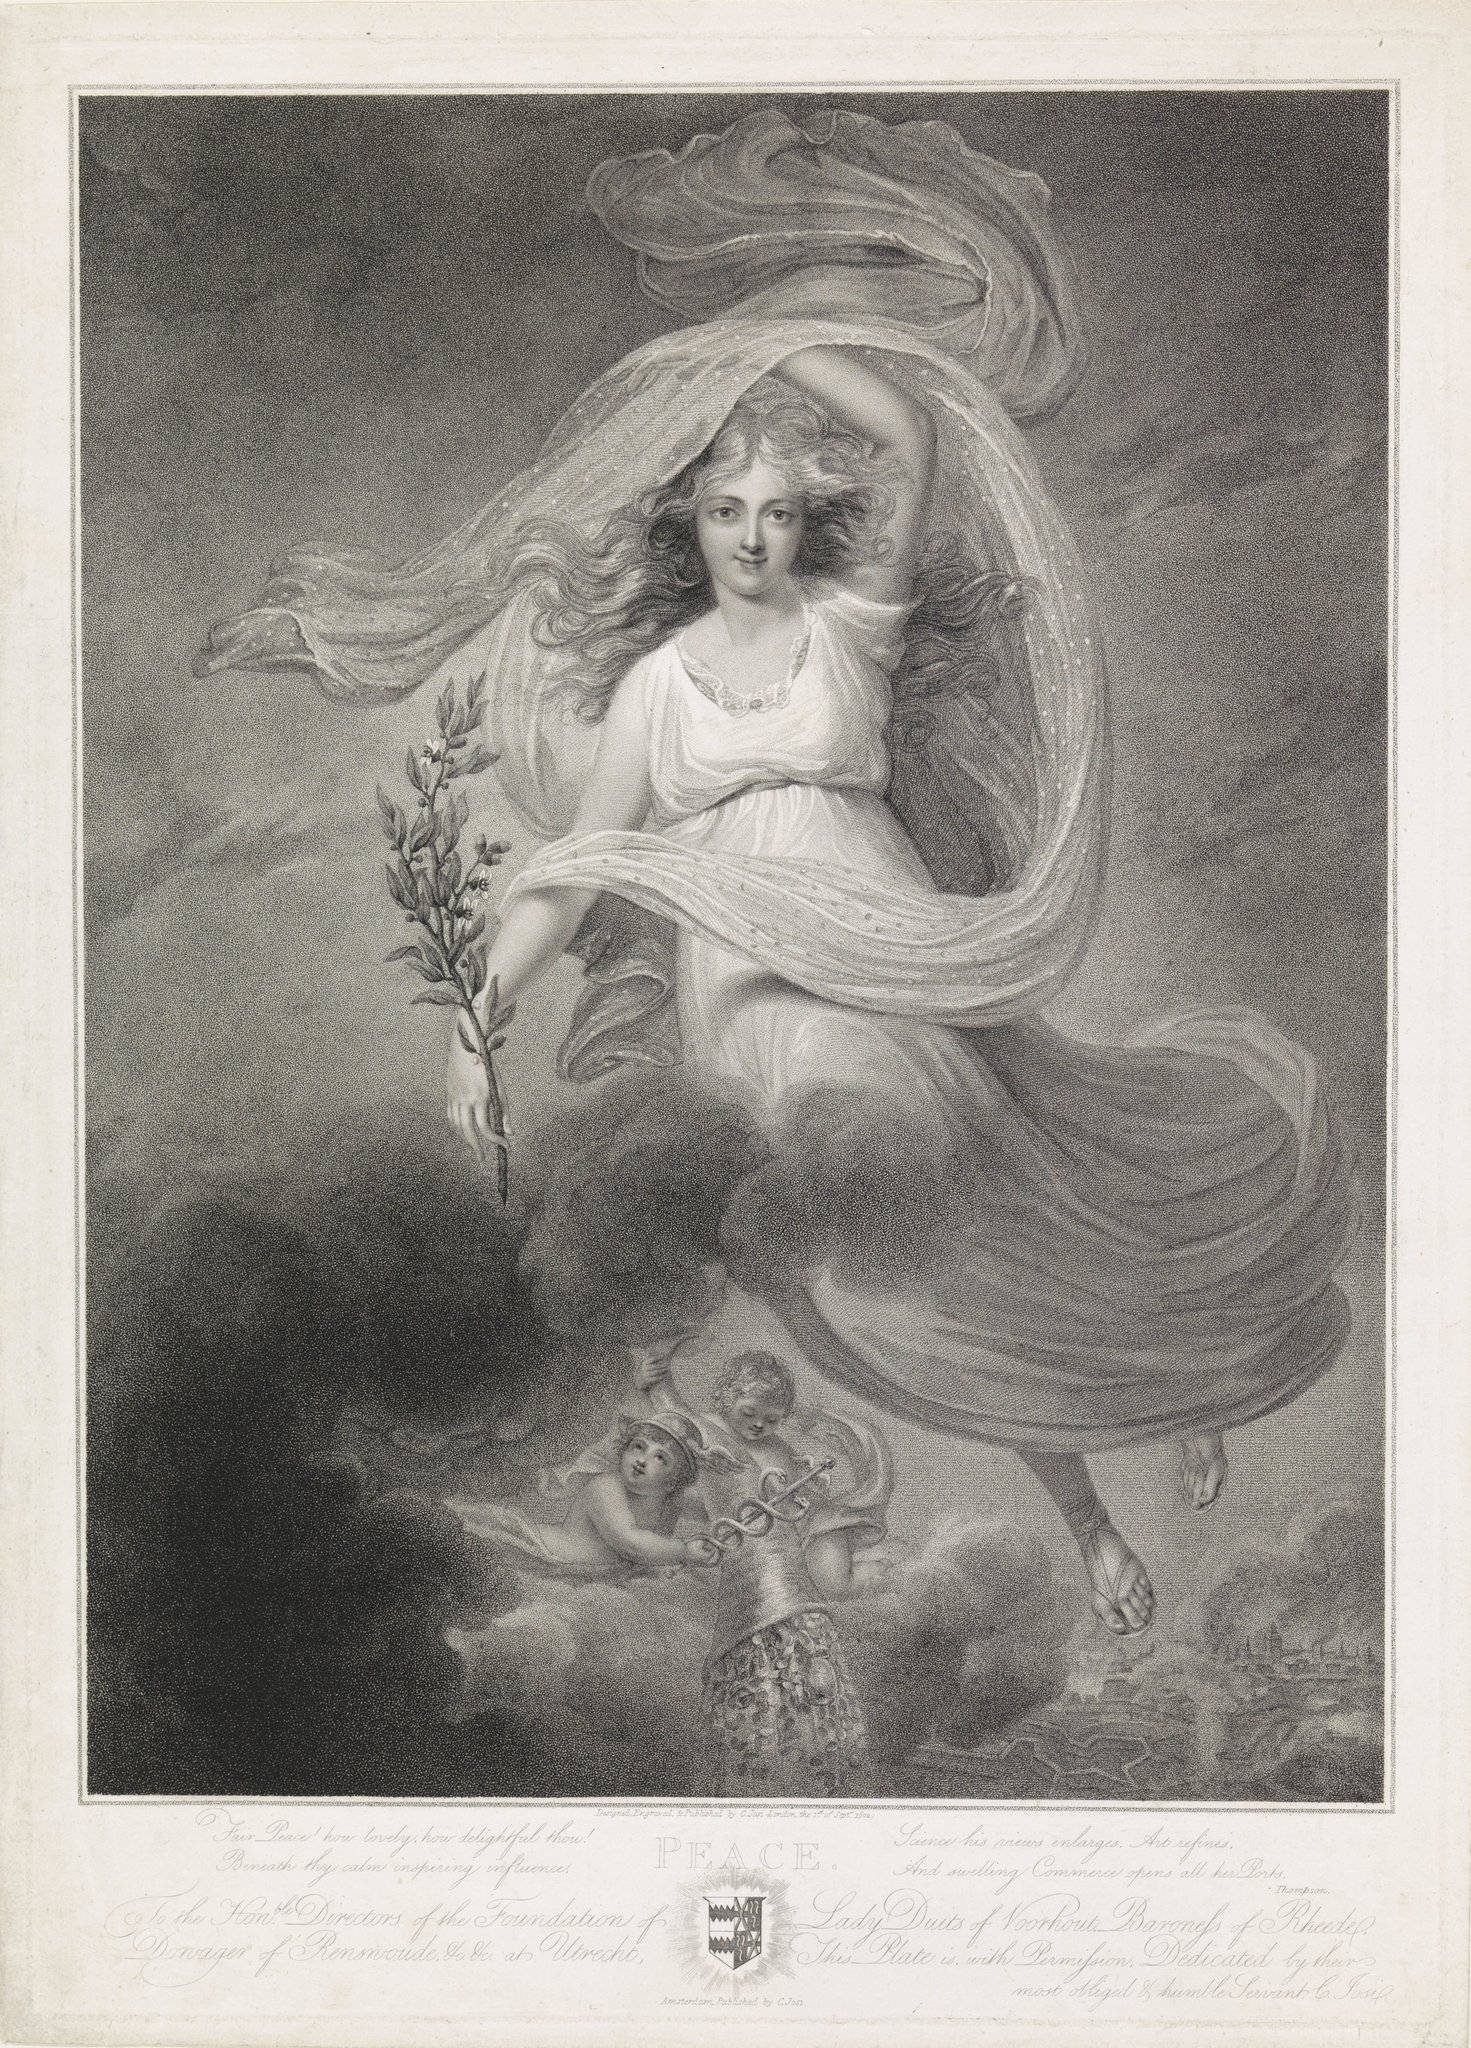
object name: print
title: Peace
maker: christiaan josi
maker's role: draughtsman, print maker, publisher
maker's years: 1765-1828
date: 1802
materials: paper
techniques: engraving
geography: london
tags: 'cornucopia', horn of plenty, symbols, allegories of peace, 'pax'; 'pace' (ripa)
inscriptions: collector's mark: Lugt 2228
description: Allegorie op de Vrede van Amiens, op 27 maart 1802, die een einde maakte aan de oorlog tussen Groot-Brittannië en de Franse republiek, Spanje en de Bataafse Republiek. Centraal zweeft de Vrede door de wolken met een olijftak in de hand. Onderaan twee putti (Koophandel en Overvloed) met een hoorn van overvloed, rechts een stad verwoest door de oorlog. In het onderschrift een vierregelig vers in het Engels en het wapen van de fundatie. Bij de prent behoort een verklaring.